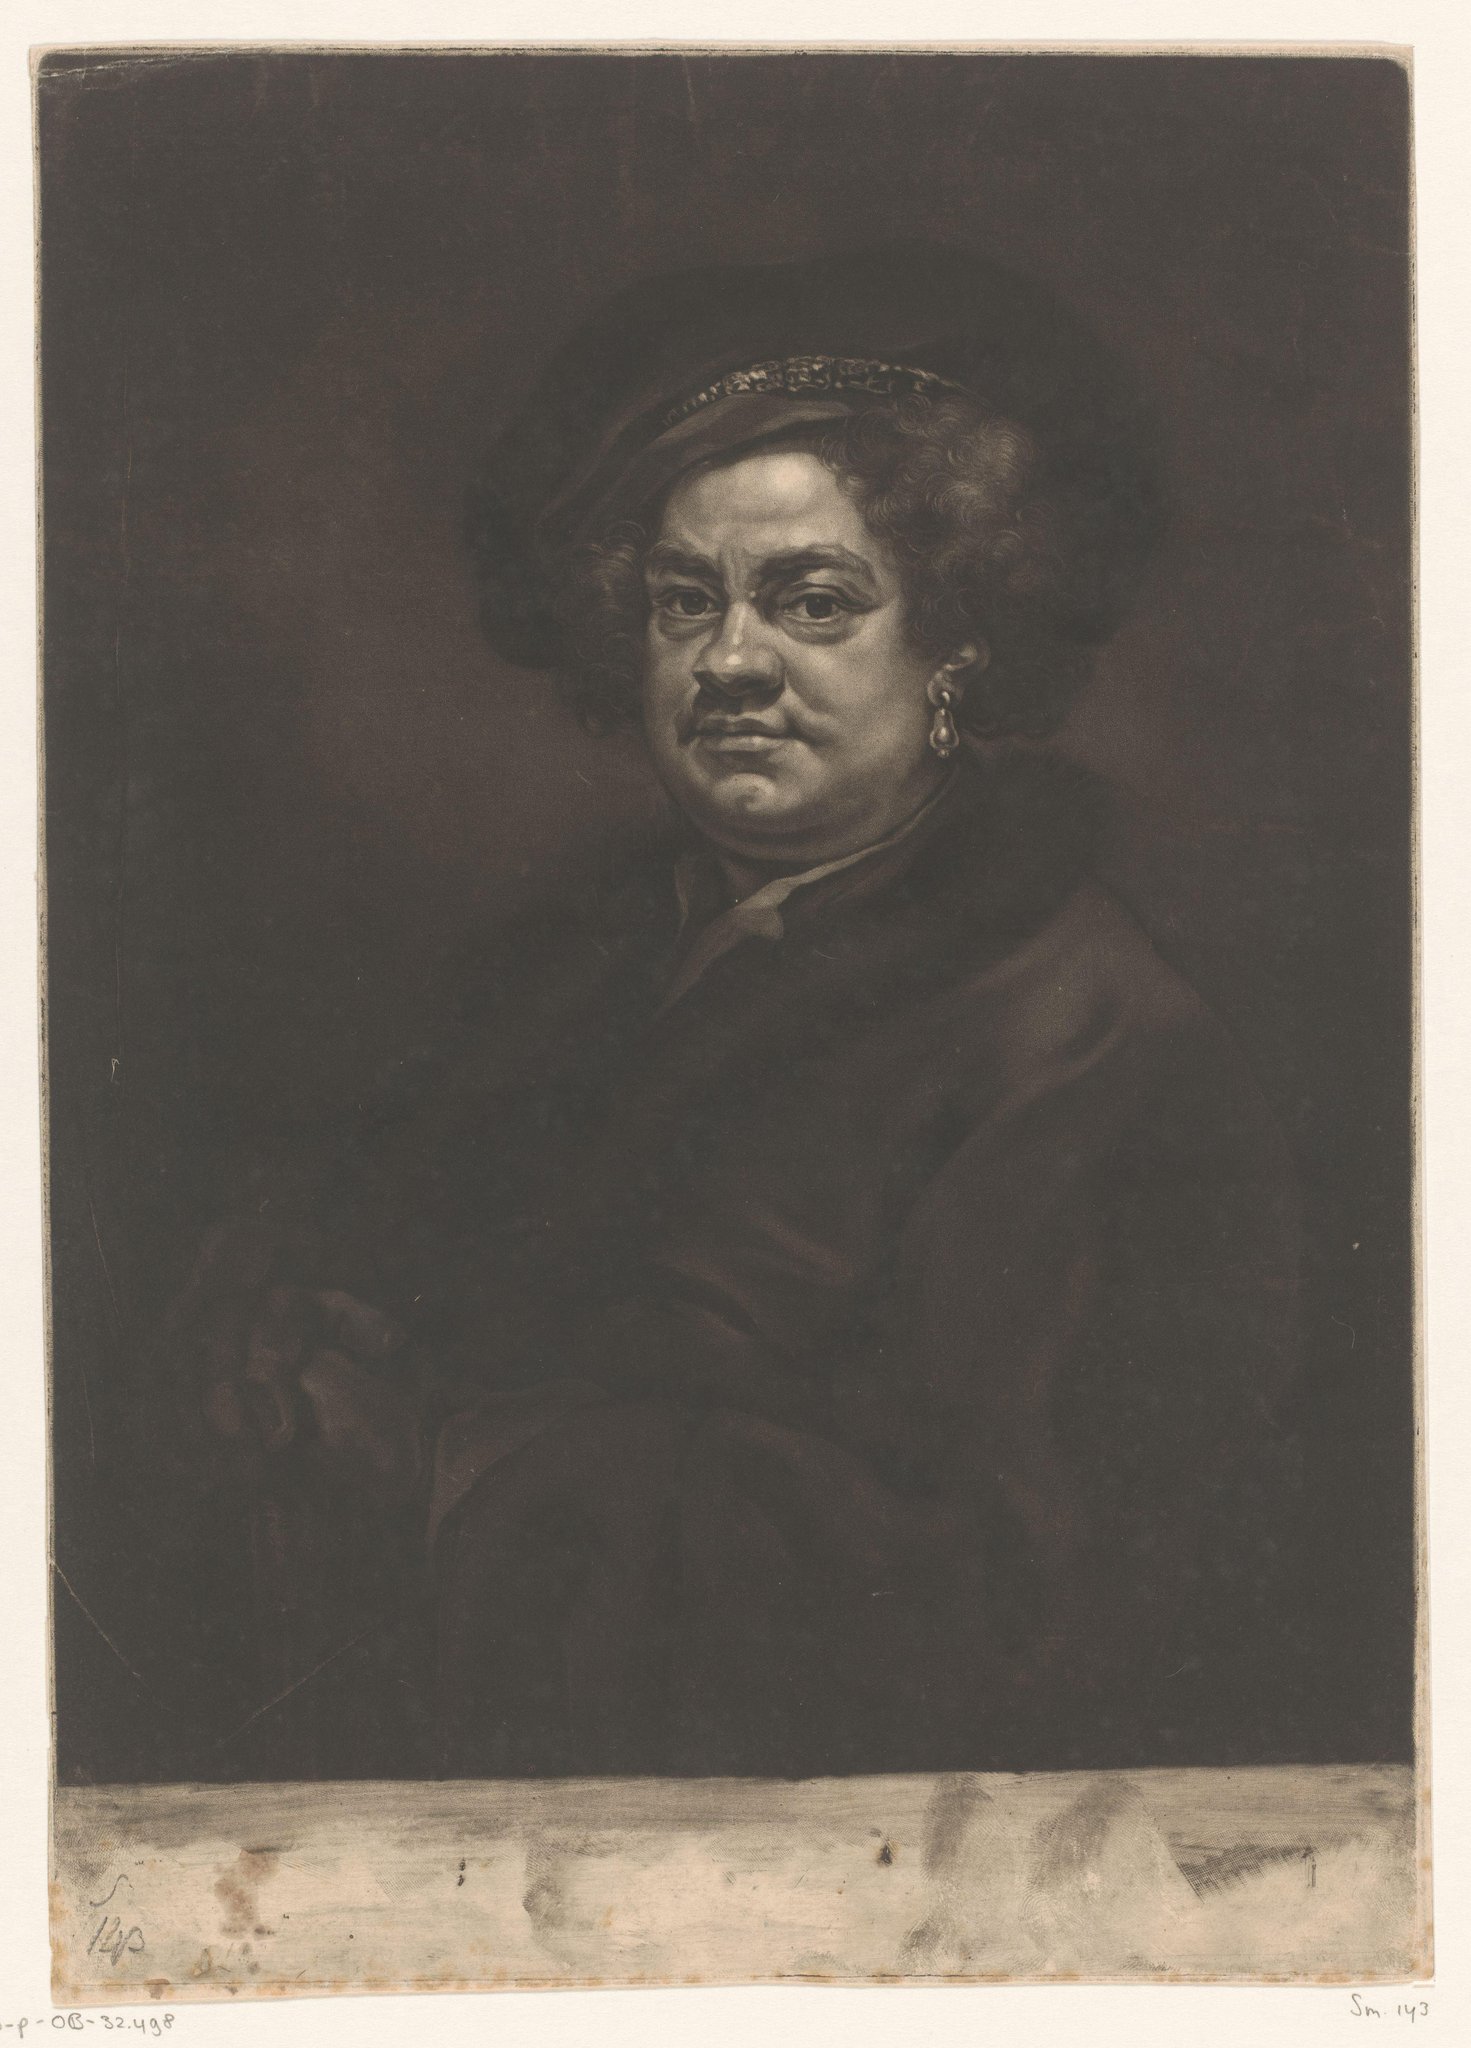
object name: print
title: Portret van John Pine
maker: james mcardell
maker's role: print maker, publisher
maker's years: 1728-1765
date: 1755-1765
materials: paper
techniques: mezzotint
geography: london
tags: london, print maker, publisher, john pine, historical persons, portrait, self-portrait of graphic artist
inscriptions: collector's mark: Lugt 240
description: Mogelijk gaat het hier niet om een eerste staat, maar om een andere plaat. Zie ook portretten van Pine met handen rustend op een stok in British Museum, toegeschreven aan McArdell en uitgegeven door George Pulley. Mogelijk zijn dat latere staten van deze prent.